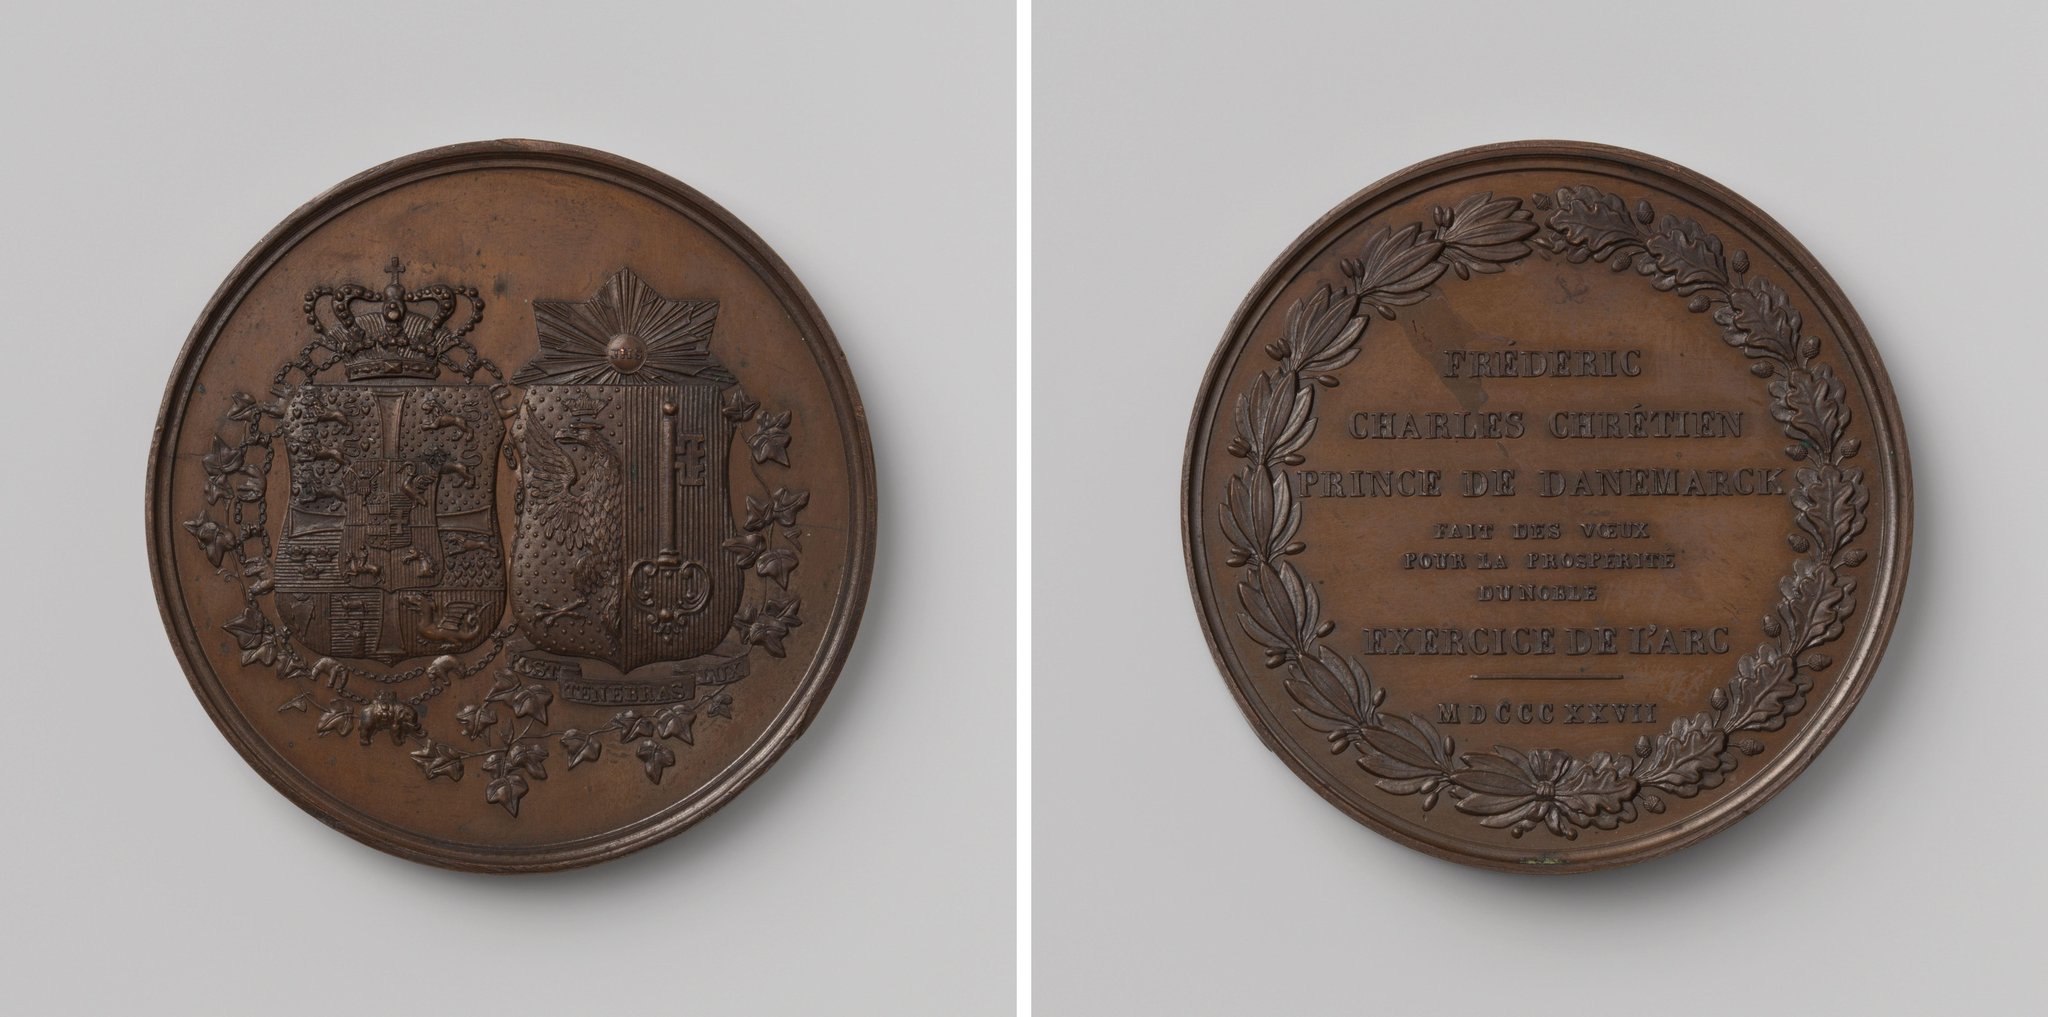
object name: marksman medal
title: Frederik Karel Christiaan, prins van Denemarken, beschermheer van het boogschieten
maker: Anonymous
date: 1827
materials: bronze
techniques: striking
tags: orde van de olifant, frederik karel christiaan (prins van denemarken)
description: Bronzen penning. Voorzijde: twee wapenschilden, waarvan linker gekroond en omhangen met orde van de Olifant, rechter onder ordeteken; daaromheen: klimoptakken. Keerzijde: opschrift binnen tot krans samengebonden lauwer- en eiketak